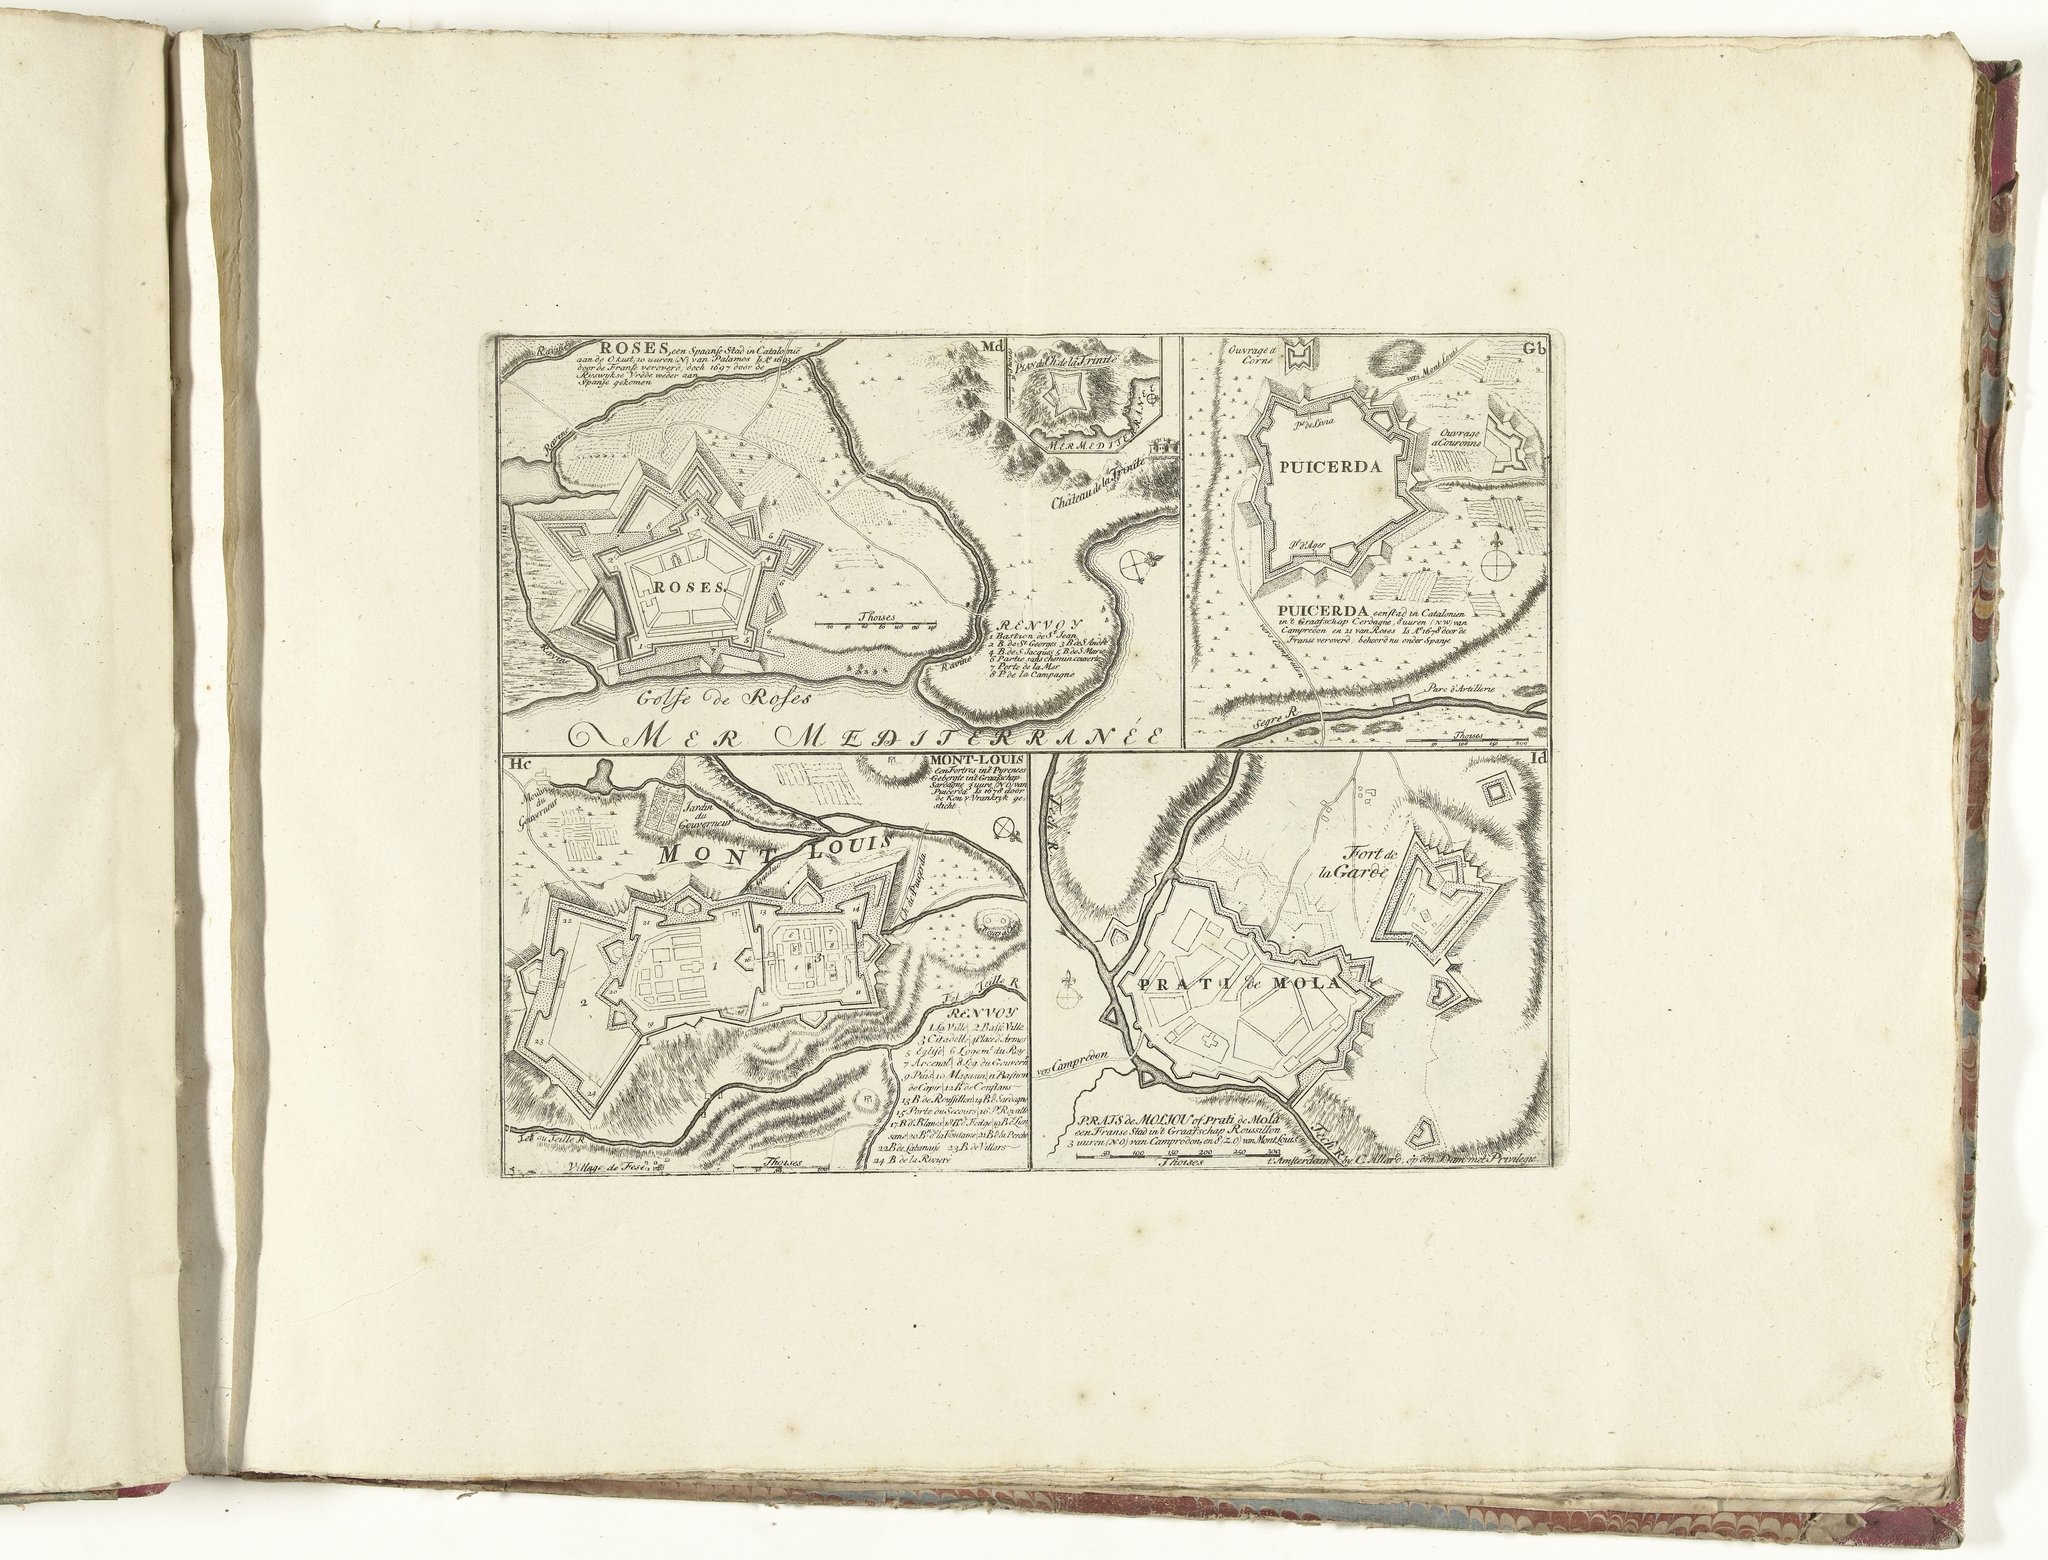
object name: print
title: Roses / Puicerda / Mont-Louis / Prati de Mola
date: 1701-1714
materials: paper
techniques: etching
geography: france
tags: maps of cities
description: Gekopieerd naar de Franse prenten in: Nicolas de Fer, Les forces de l'Europe, ou description des principales villes, avec leurs fortifications : dessignées par les meilleurs ingenieurs, particulierement celles ... de la France, dont les plans ont esté levez par M. de Vauban, Nicolas de Fer, Parijs 1693-1696, of andere voorbeelden.